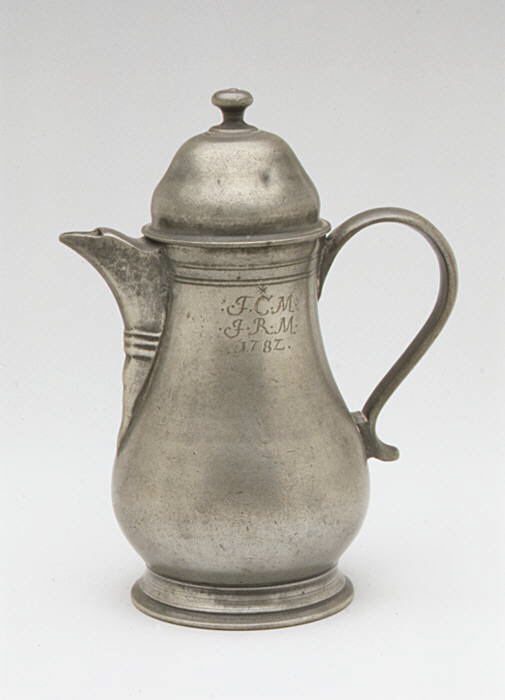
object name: coffeepot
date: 1782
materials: pewter